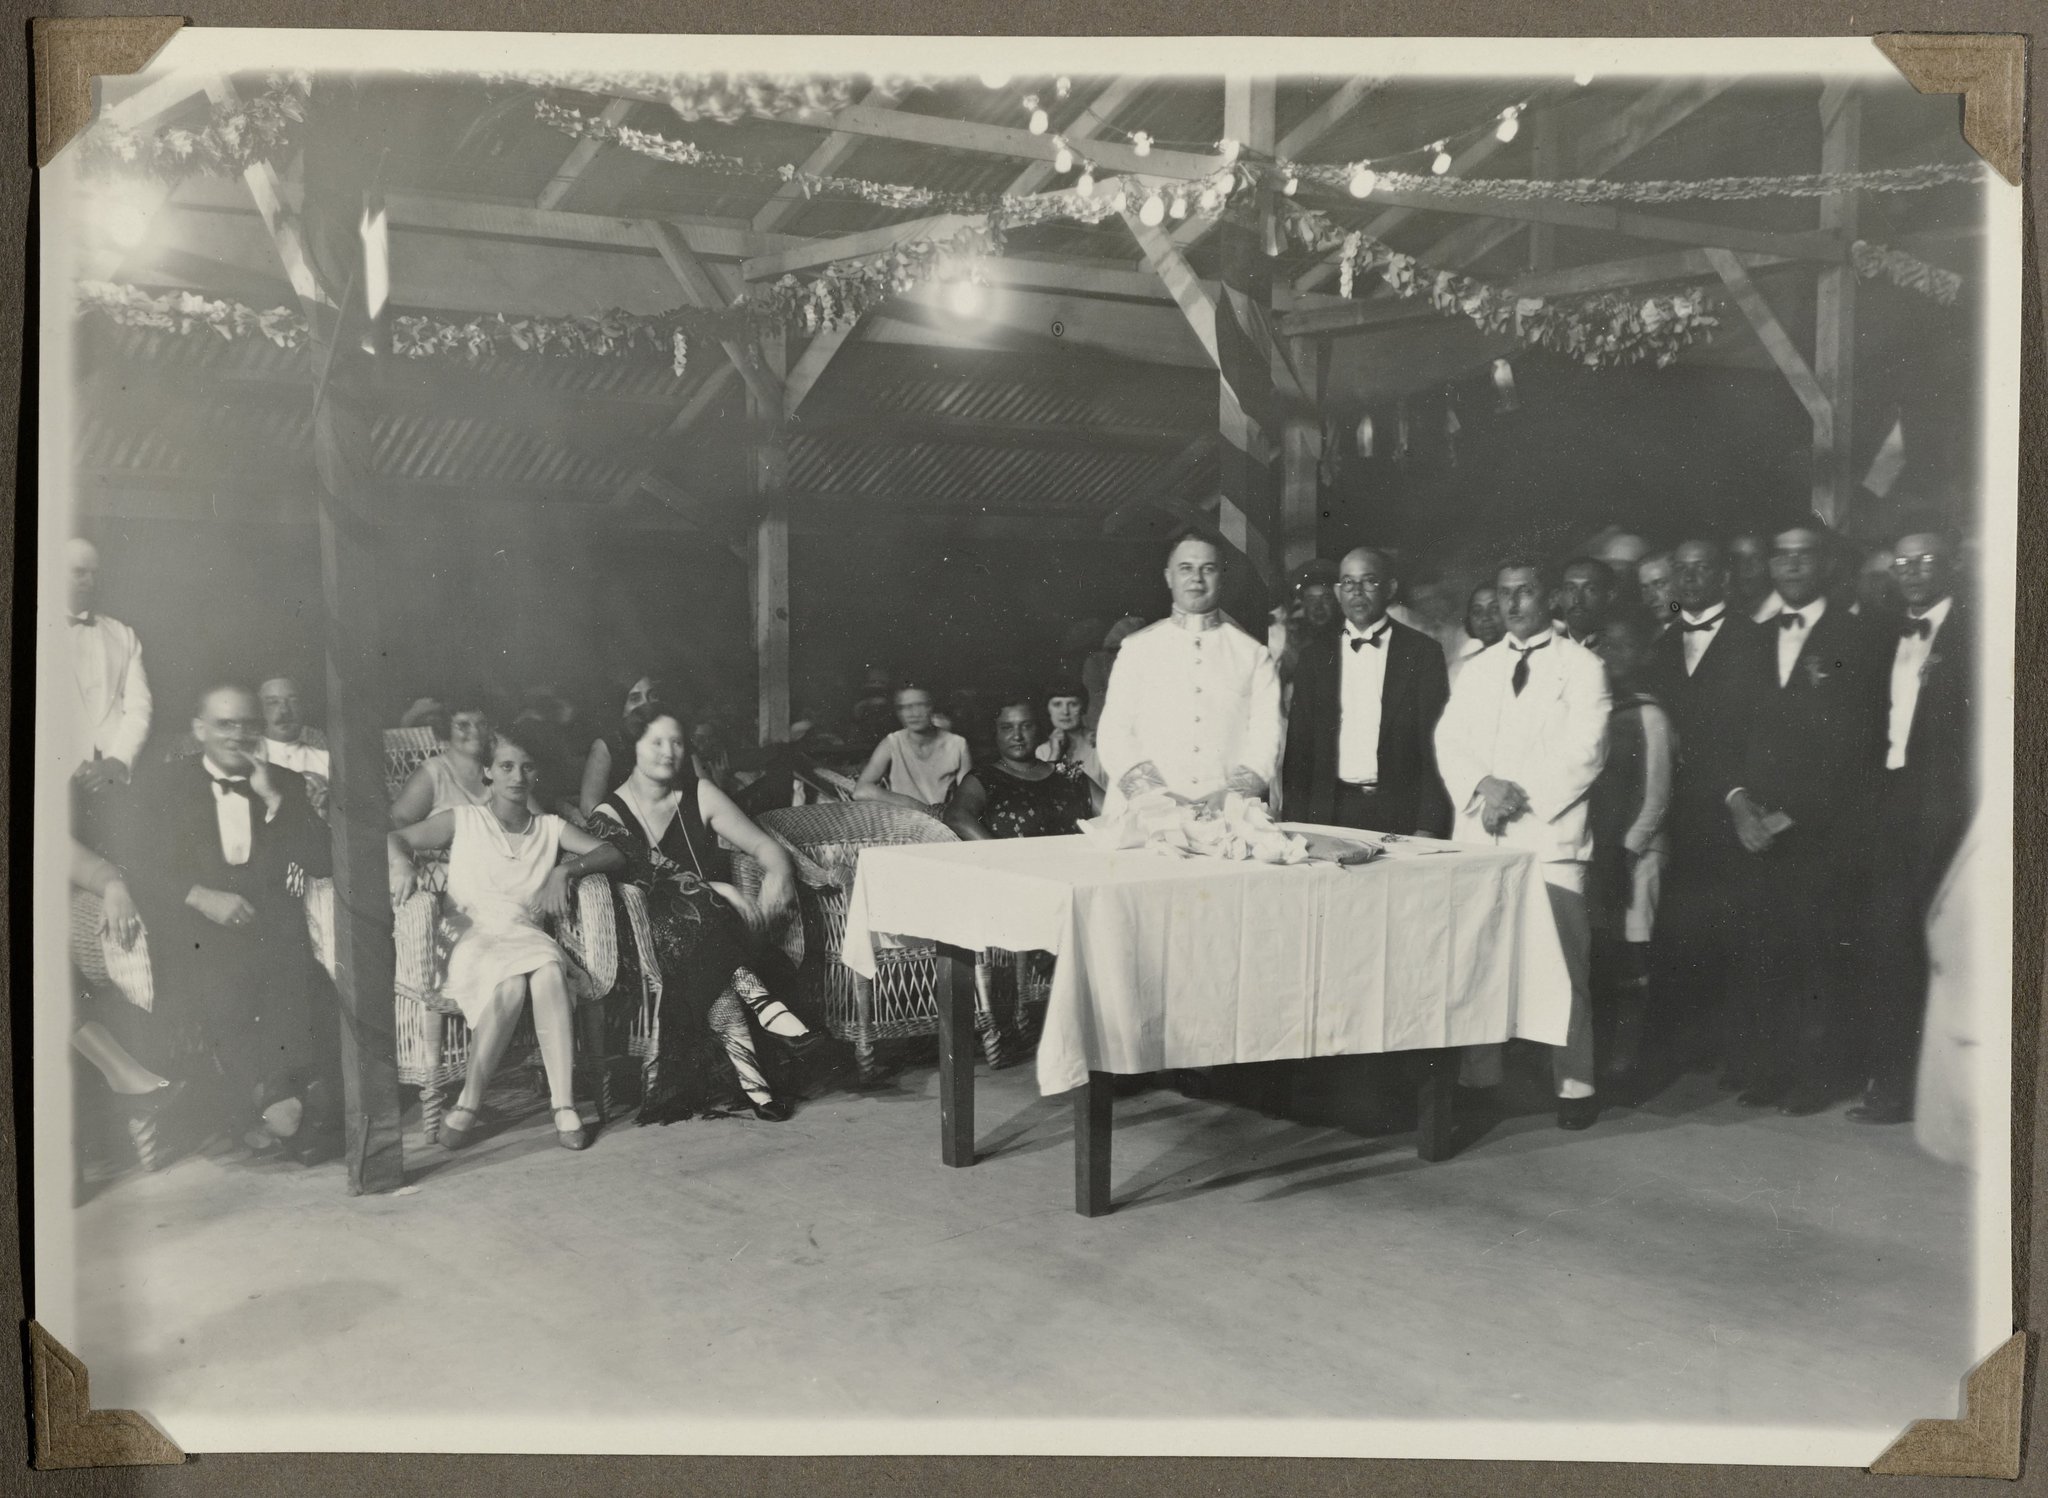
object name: photograph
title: Feestelijke bijeenkomst met Nederlanders en Surinamers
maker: Anonymous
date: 1925-1927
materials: photographic support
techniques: photography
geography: suriname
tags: anonymous historical persons portrayed in a group, in a group-portrait, suriname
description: Feestelijke bijeenkomst met Nederlanders en Surinamers. Drie mannen staande aan een tafel, links op de eerste rij Edith Jetten in een stoel. Foto met hoekjes bevestigd op een bladzijde van een albumblad in het fotoalbum over de familie Jetten en het leven en werken in de mijnstad Moengo in Suriname rond 1927.